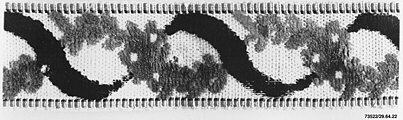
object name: galloon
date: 1701-1900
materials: silk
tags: flowers